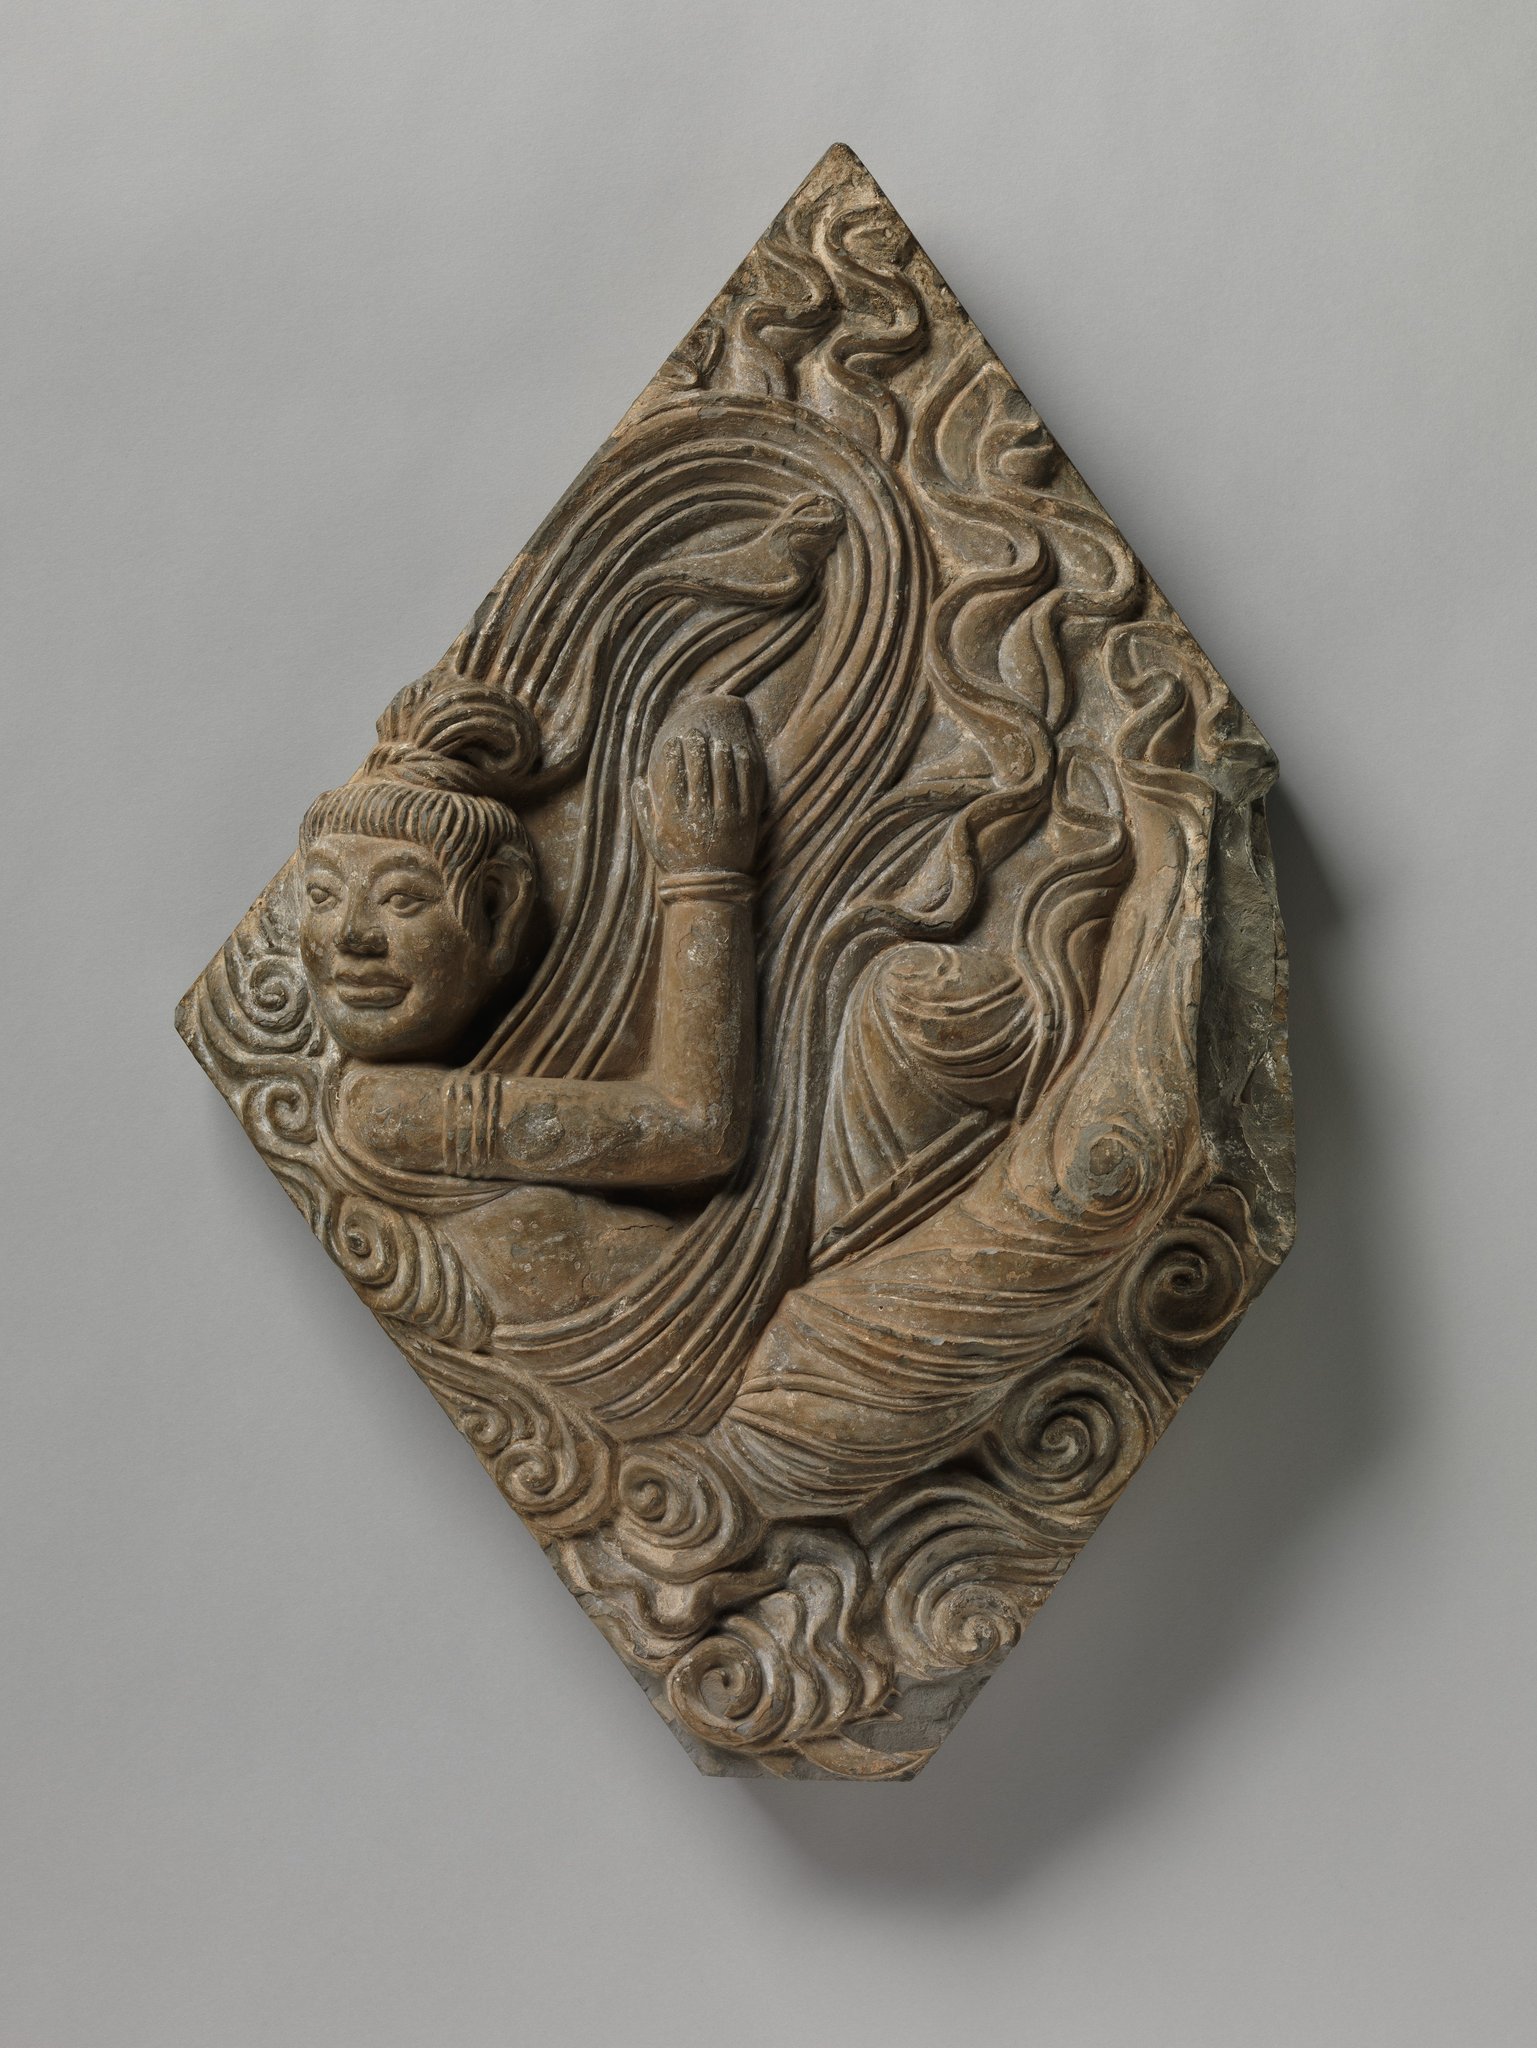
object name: relief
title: Flying Celestial Apsara (Feitian 飛天)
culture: chinese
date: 601-700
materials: earthenware, pigment